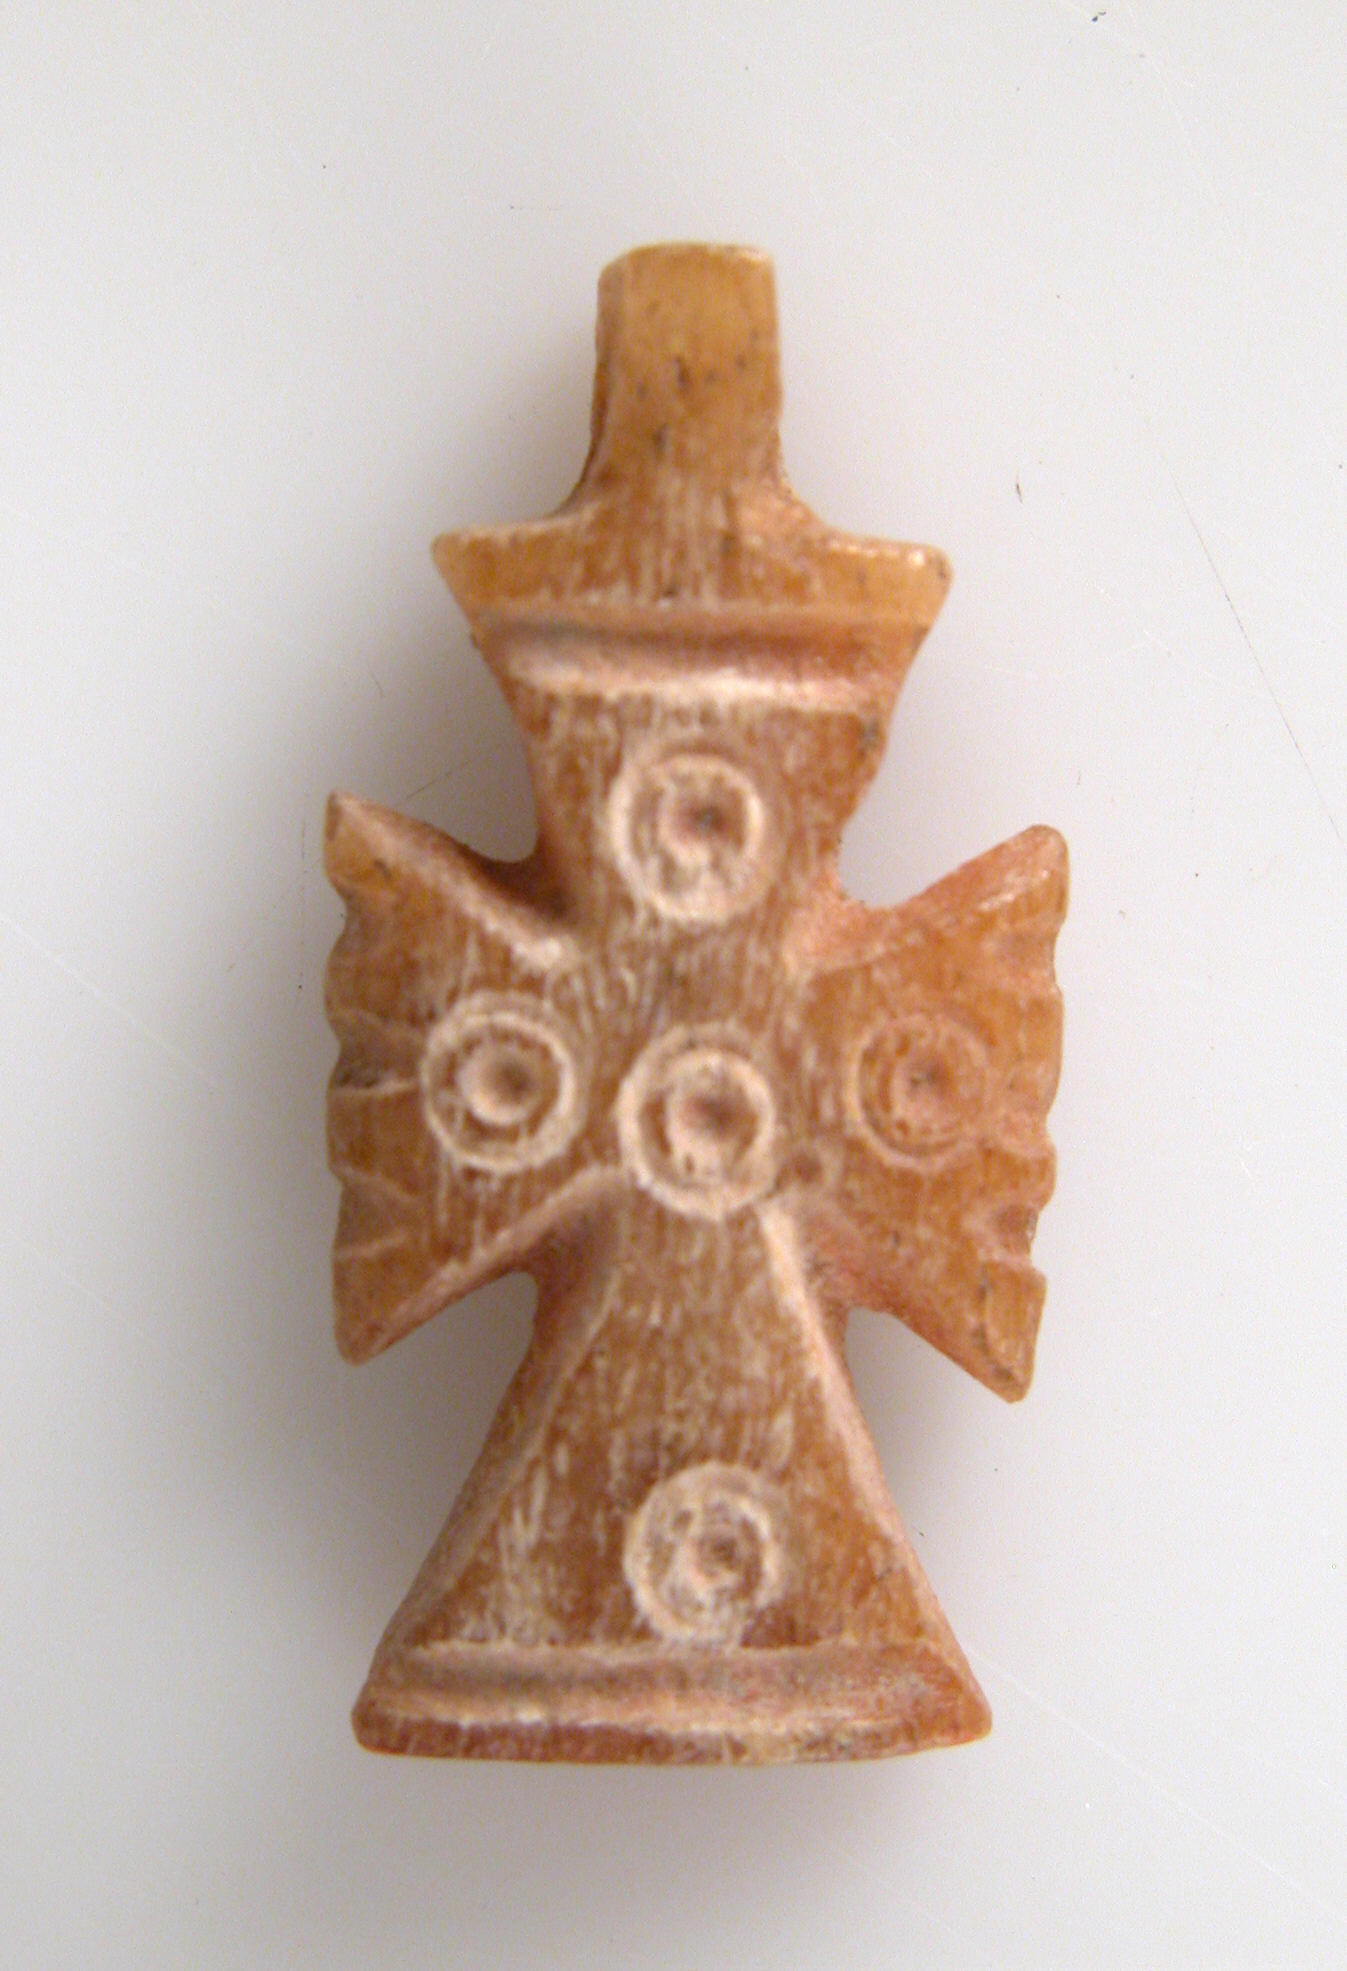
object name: pendant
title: Pendant Cross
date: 401-700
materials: bone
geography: egypt